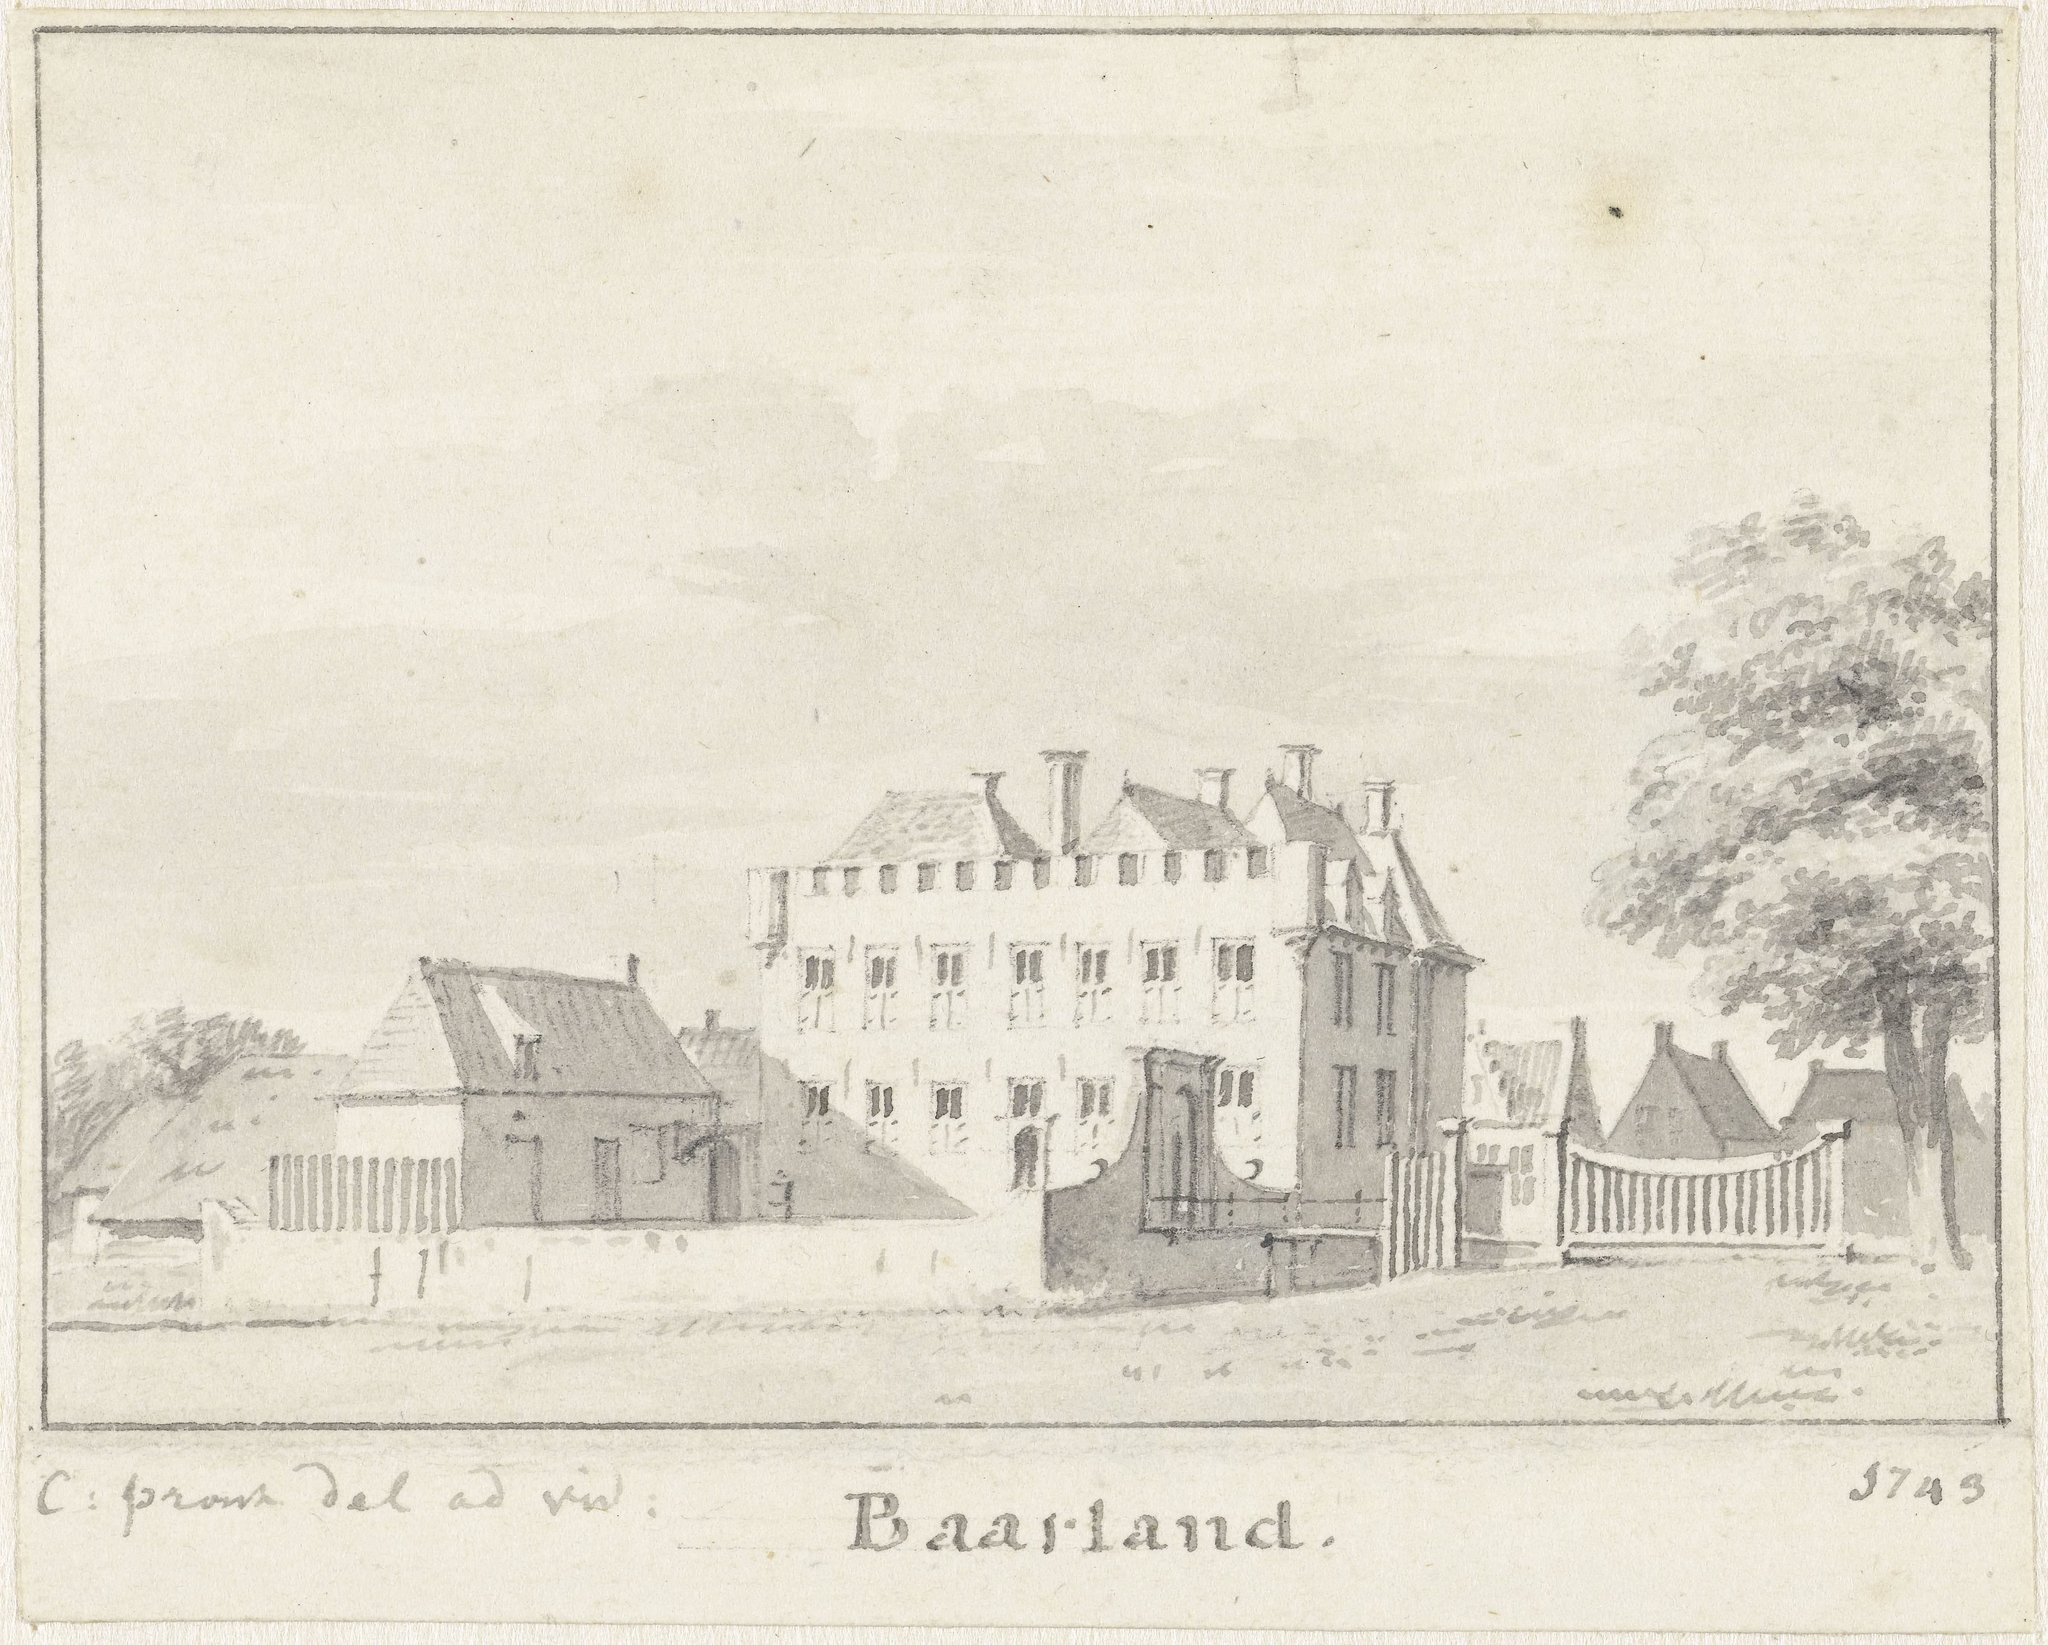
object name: drawing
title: Het kasteel te Baarland, Zuid-Beveland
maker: cornelis pronk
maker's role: draughtsman, painter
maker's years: 1691-1759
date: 1748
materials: ink, paper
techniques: brush, pen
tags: prospect of village, silhouette of village, castle, rural housing, e.g. country-house, villa, cottage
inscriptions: caption: ‘C:pronk del ad viv: / Baarland / 1748’